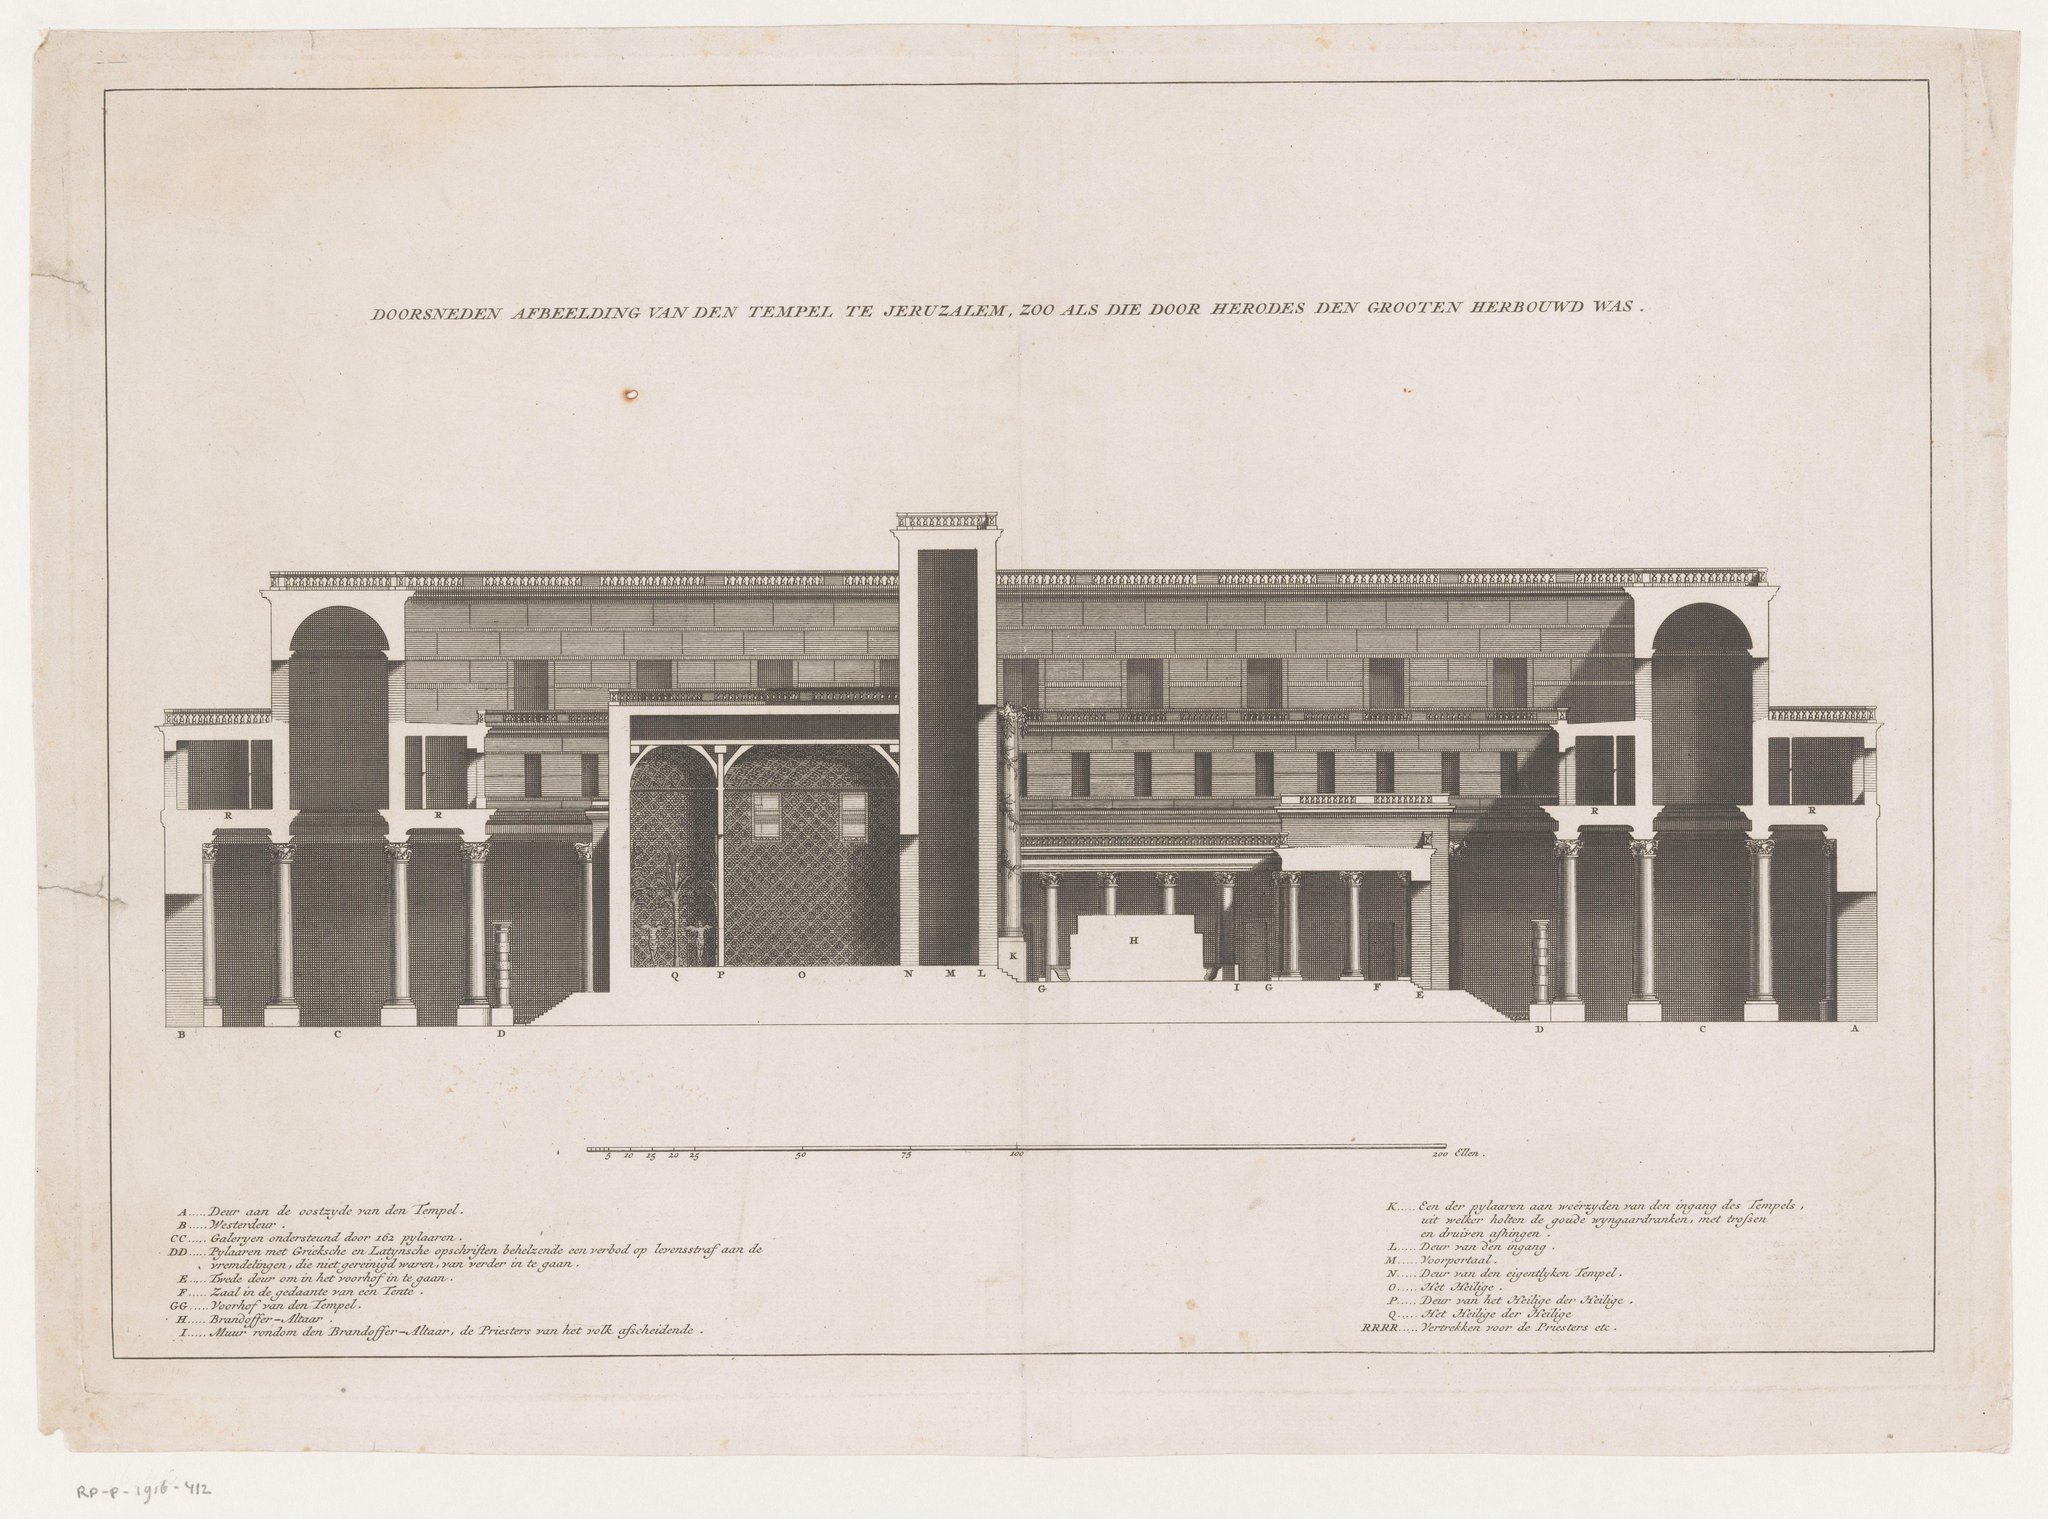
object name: print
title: Doorsneden afbeelding van den tempel te Jeruzalem, zoo als die door Herodes den grooten herbouwd was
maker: Anonymous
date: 1725-1727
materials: paper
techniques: engraving, etching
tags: temple of solomon (1 kings 5-9; 2 chronicles 2-7), exterior ~ architectural design or model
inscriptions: collector's mark: Lugt 2228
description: Prent verschenen in: Calmet, Augustin. Het algemeen groot historisch, oordeelkundig, chronologisch, geografisch en letterlyk naam- en woord-boek van den gantschen H. Bybel. Amsterdam: R. en J. Wetstein en W. Smith, 1725-1727.